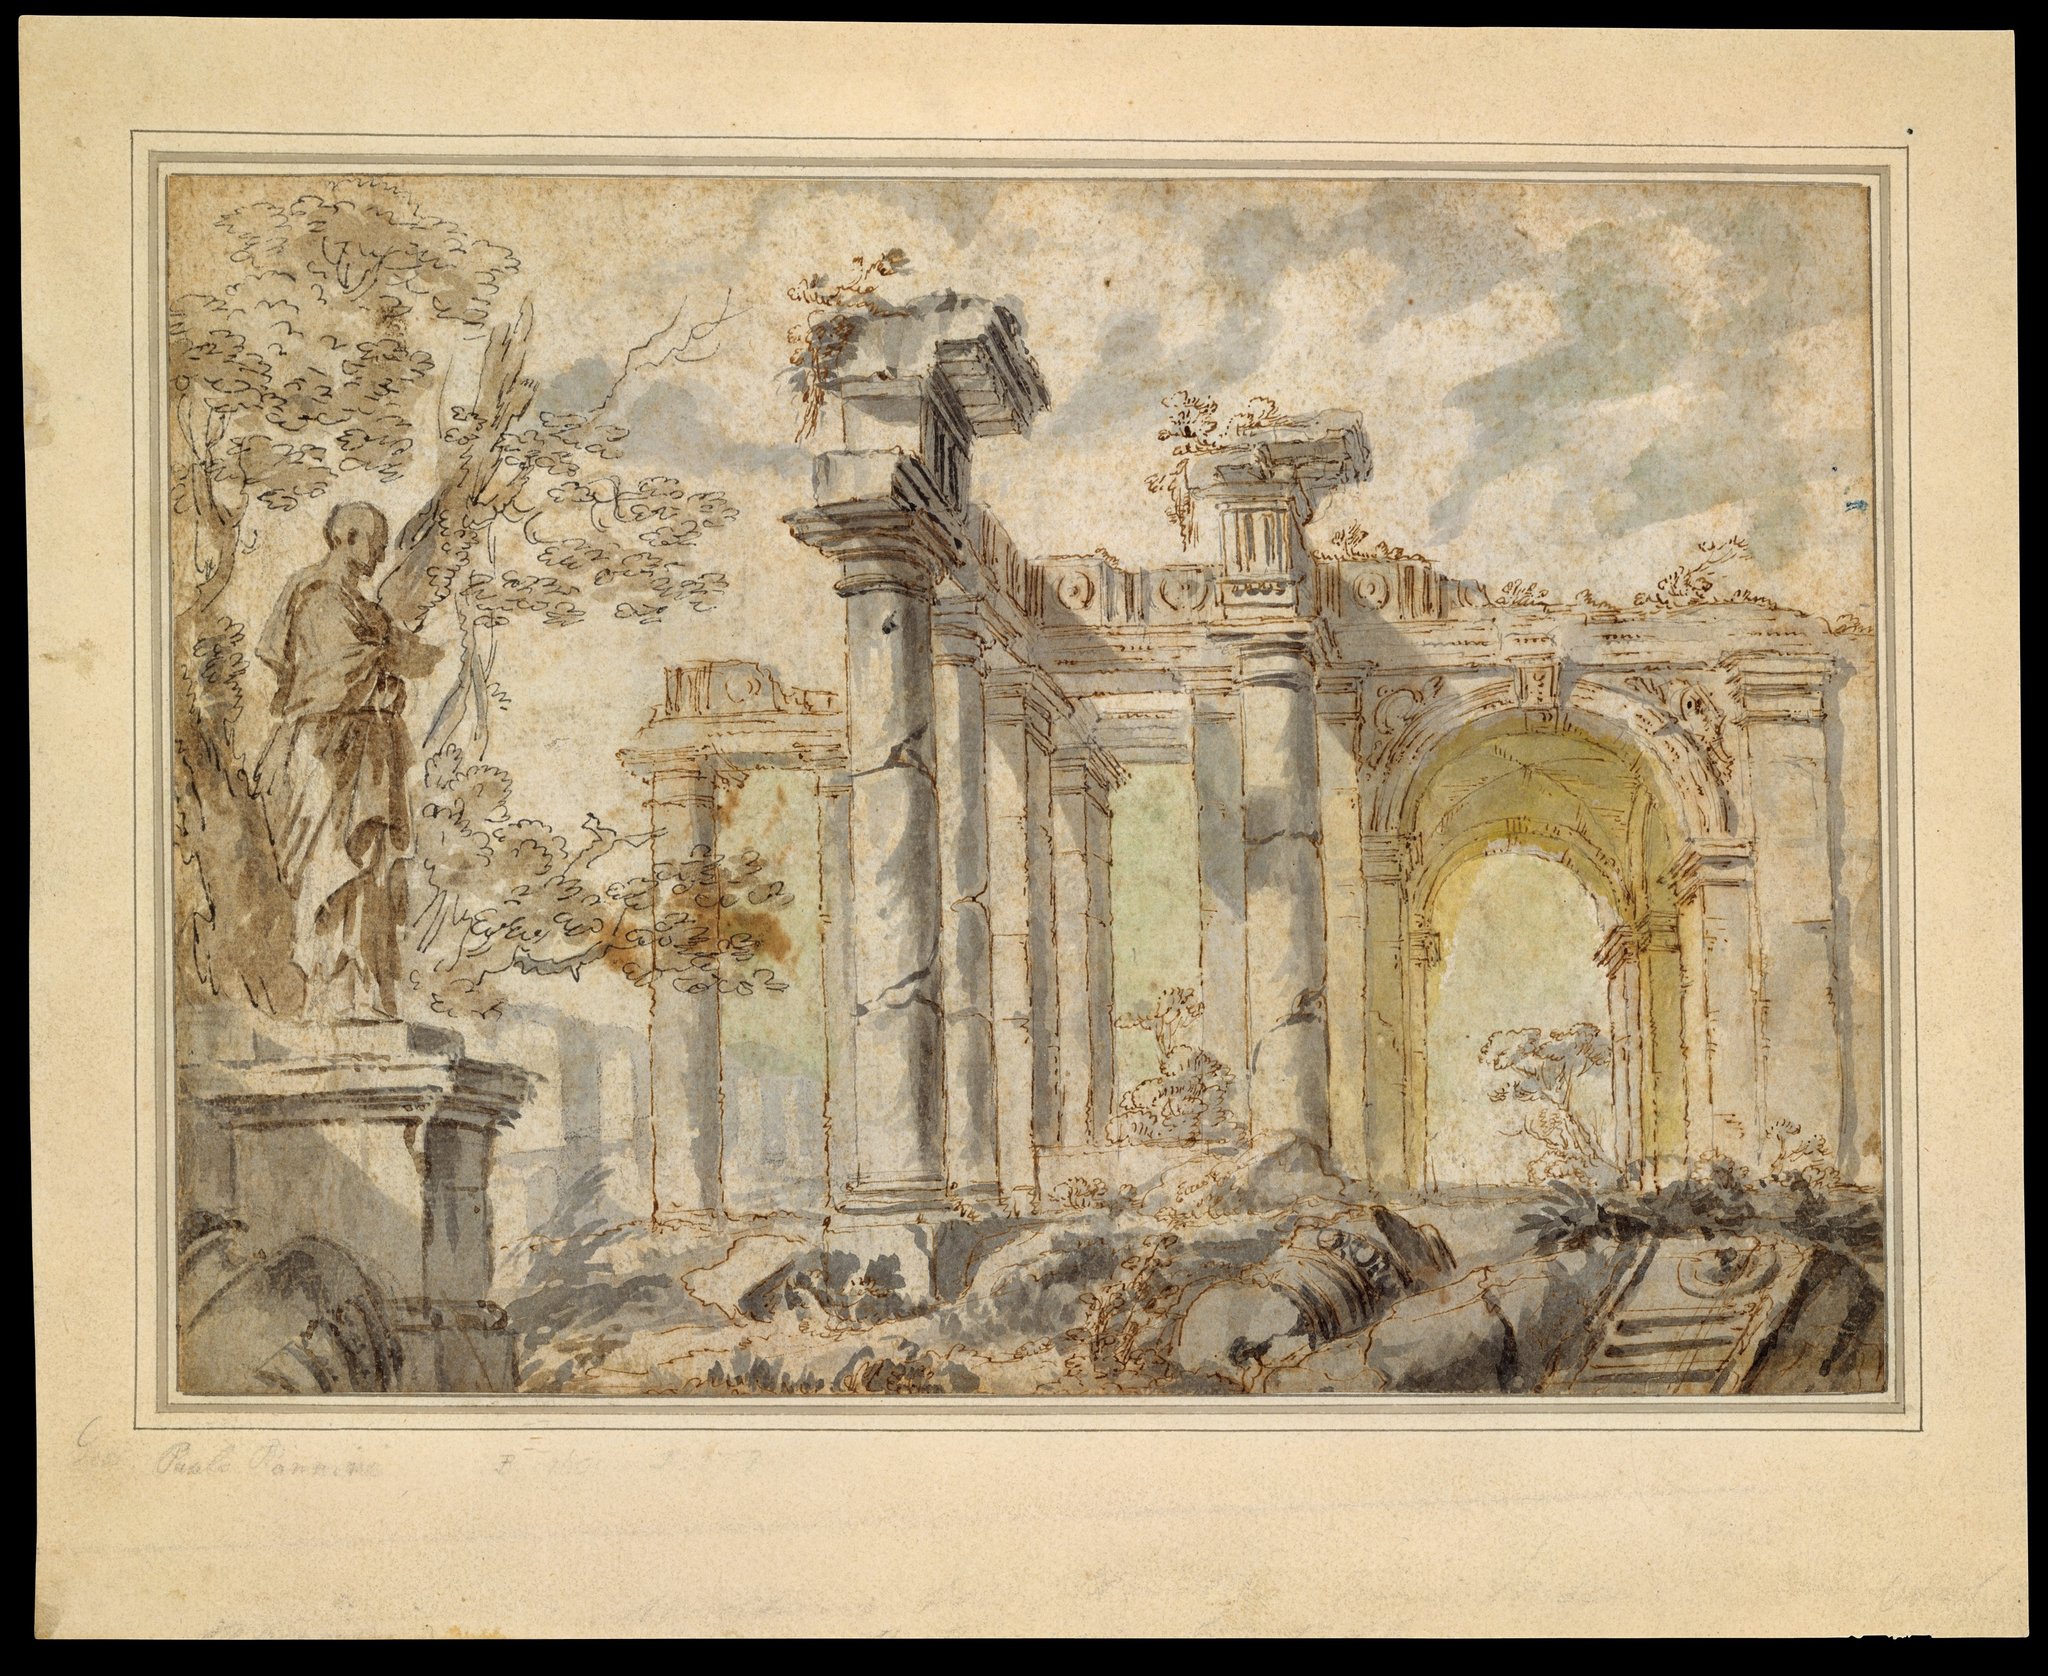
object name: drawing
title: Ruins, with a Statue on the Left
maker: giovanni paolo panini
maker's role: artist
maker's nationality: italian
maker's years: 1691-1765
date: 1728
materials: ink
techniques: pen, wash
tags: architecture,ruins